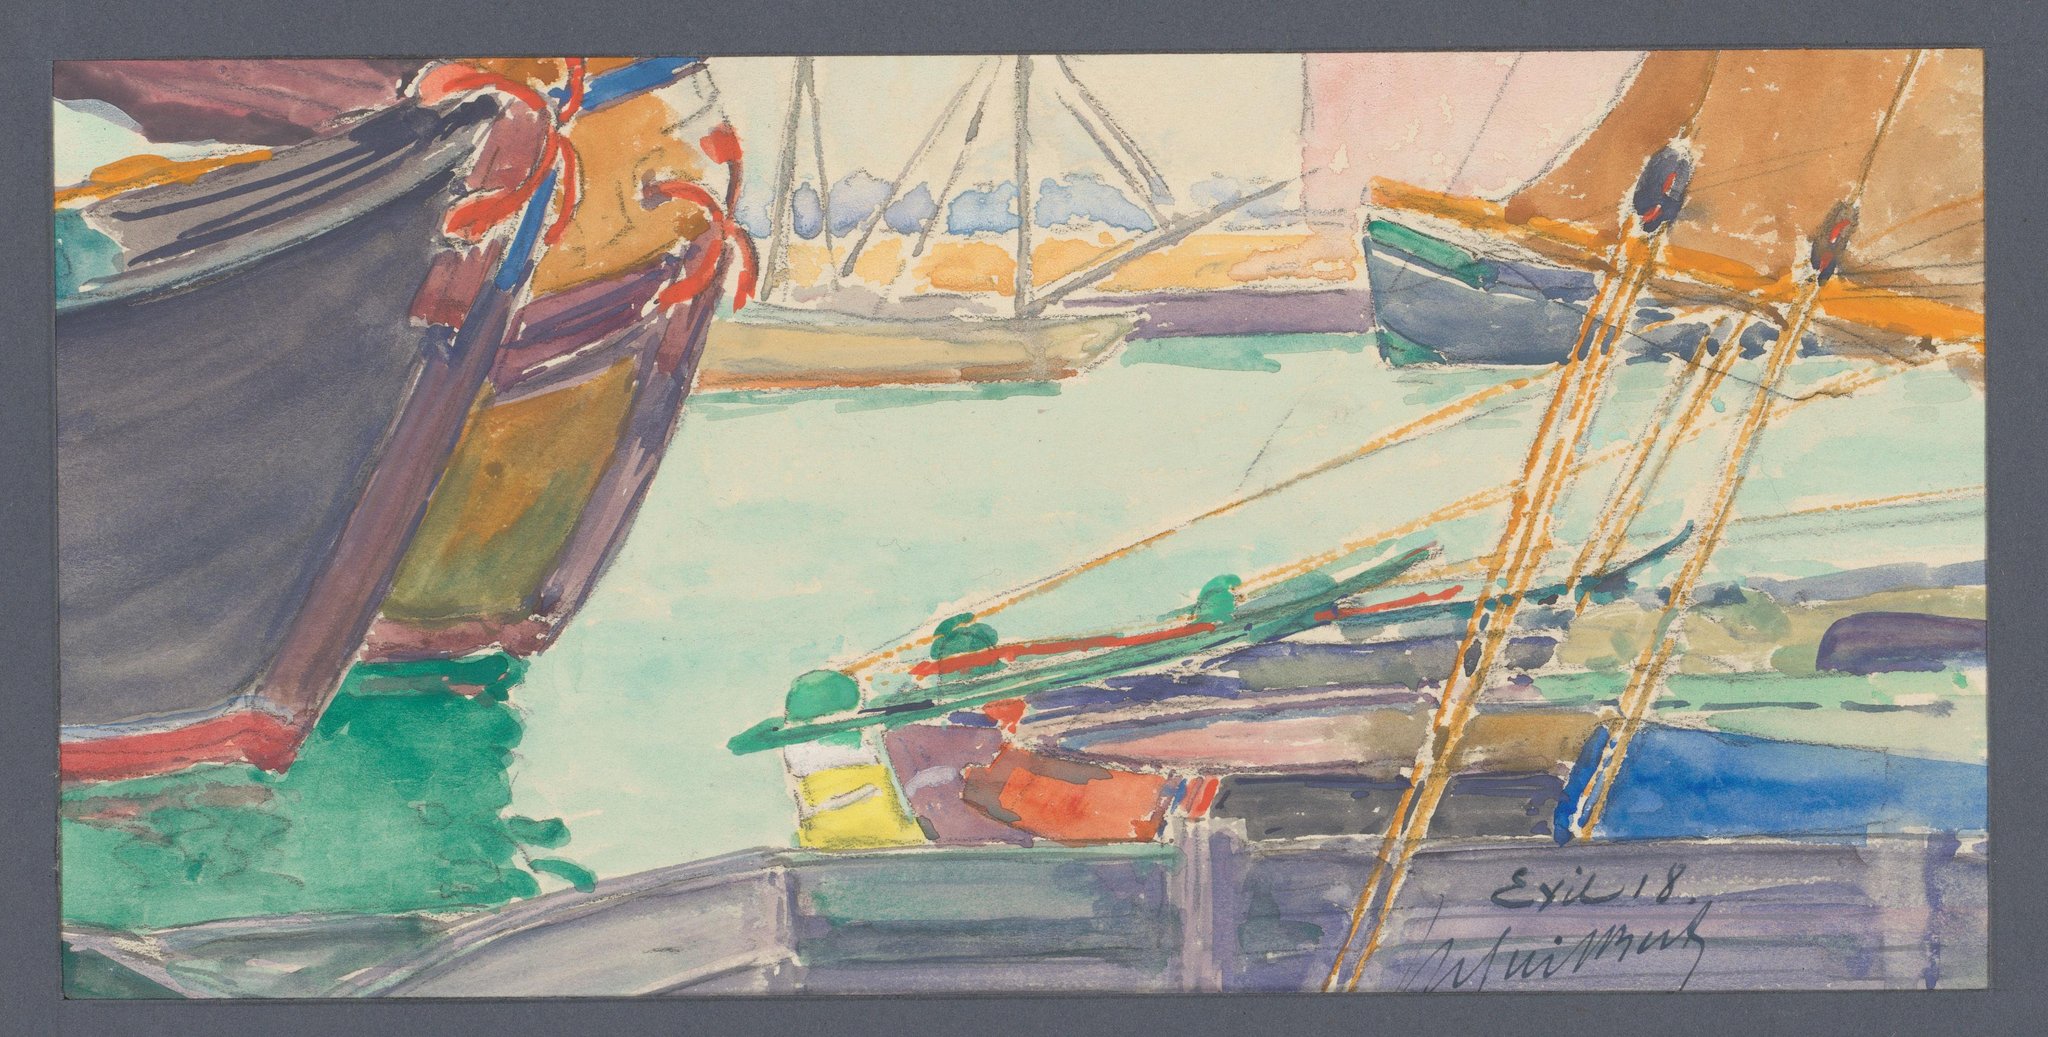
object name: watercolor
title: Schepen in een kanaal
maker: maurice guilbert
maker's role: draughtsman, painter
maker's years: 1876-1938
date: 1918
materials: chalk, paper, watercolor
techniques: brush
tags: canal, ships (in general) - cc - more than one ship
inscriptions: collector's mark: Lugt 2228